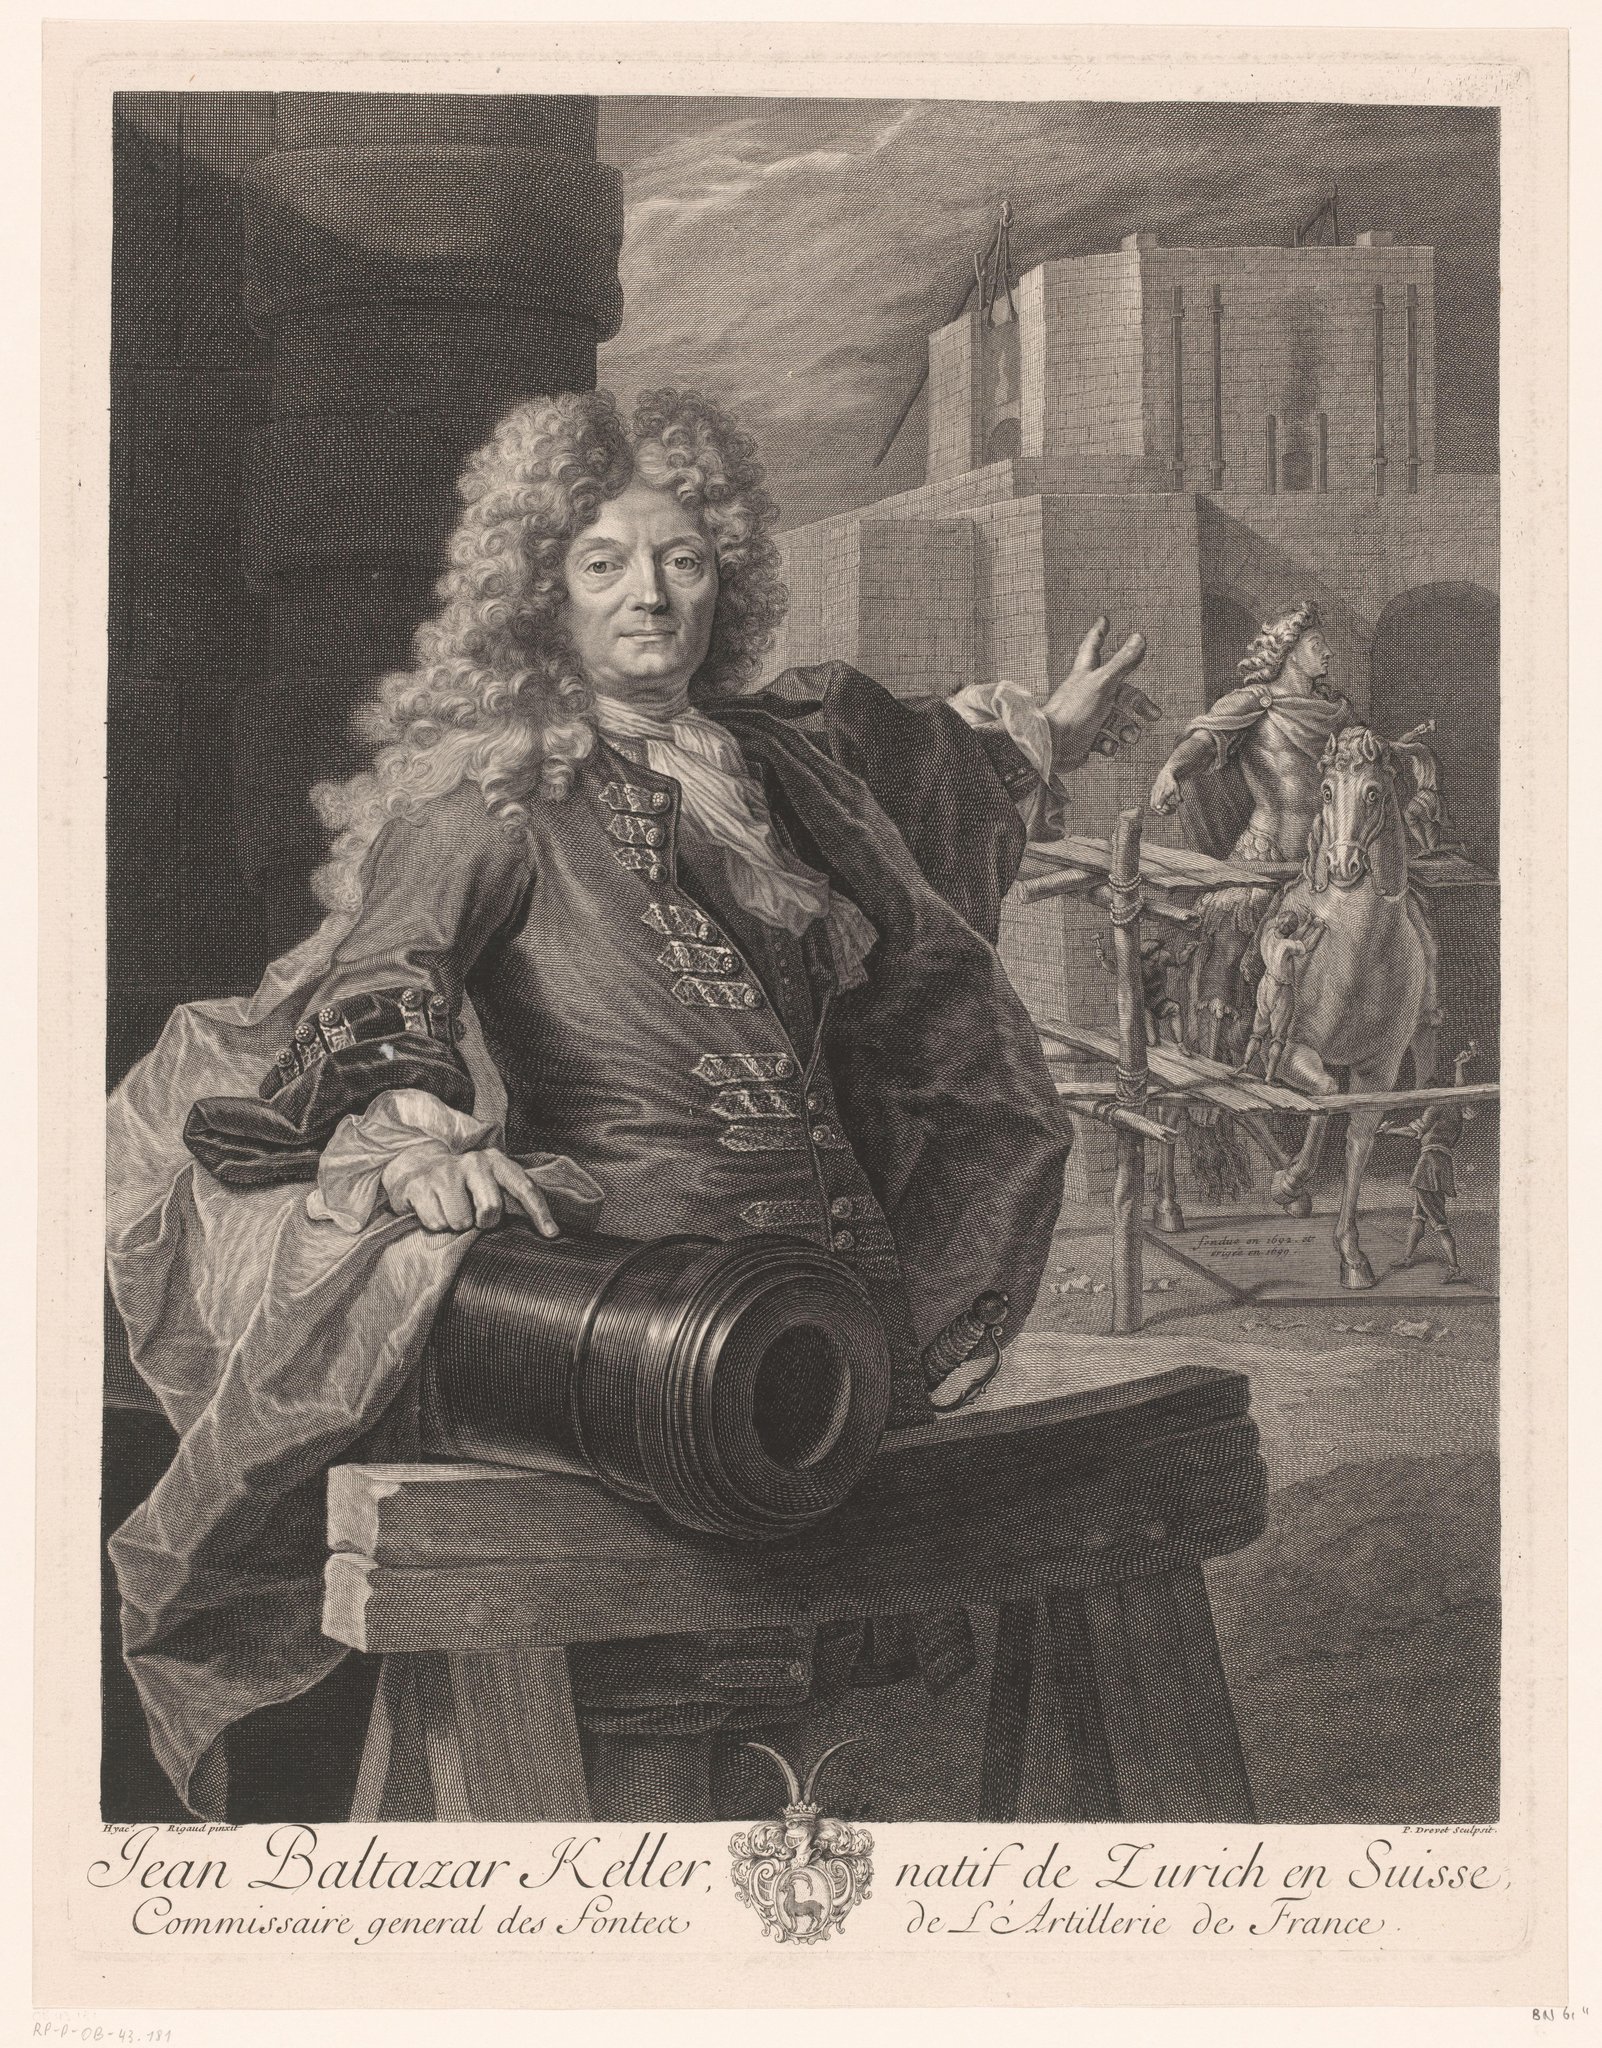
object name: print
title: Portret van Jean-Balthazar Keller aan een kanon, wijzend naar een ruiterstandbeeld van Lodewijk XIV van Frankrijk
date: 1693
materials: paper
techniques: engraving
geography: france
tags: paris, lodewijk xiv (koning van frankrijk), portrait, self-portrait of sculptor, firearms: cannon, equestrian statue, ruler, sovereign, armorial bearing, heraldry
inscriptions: collector's mark: Lugt 240